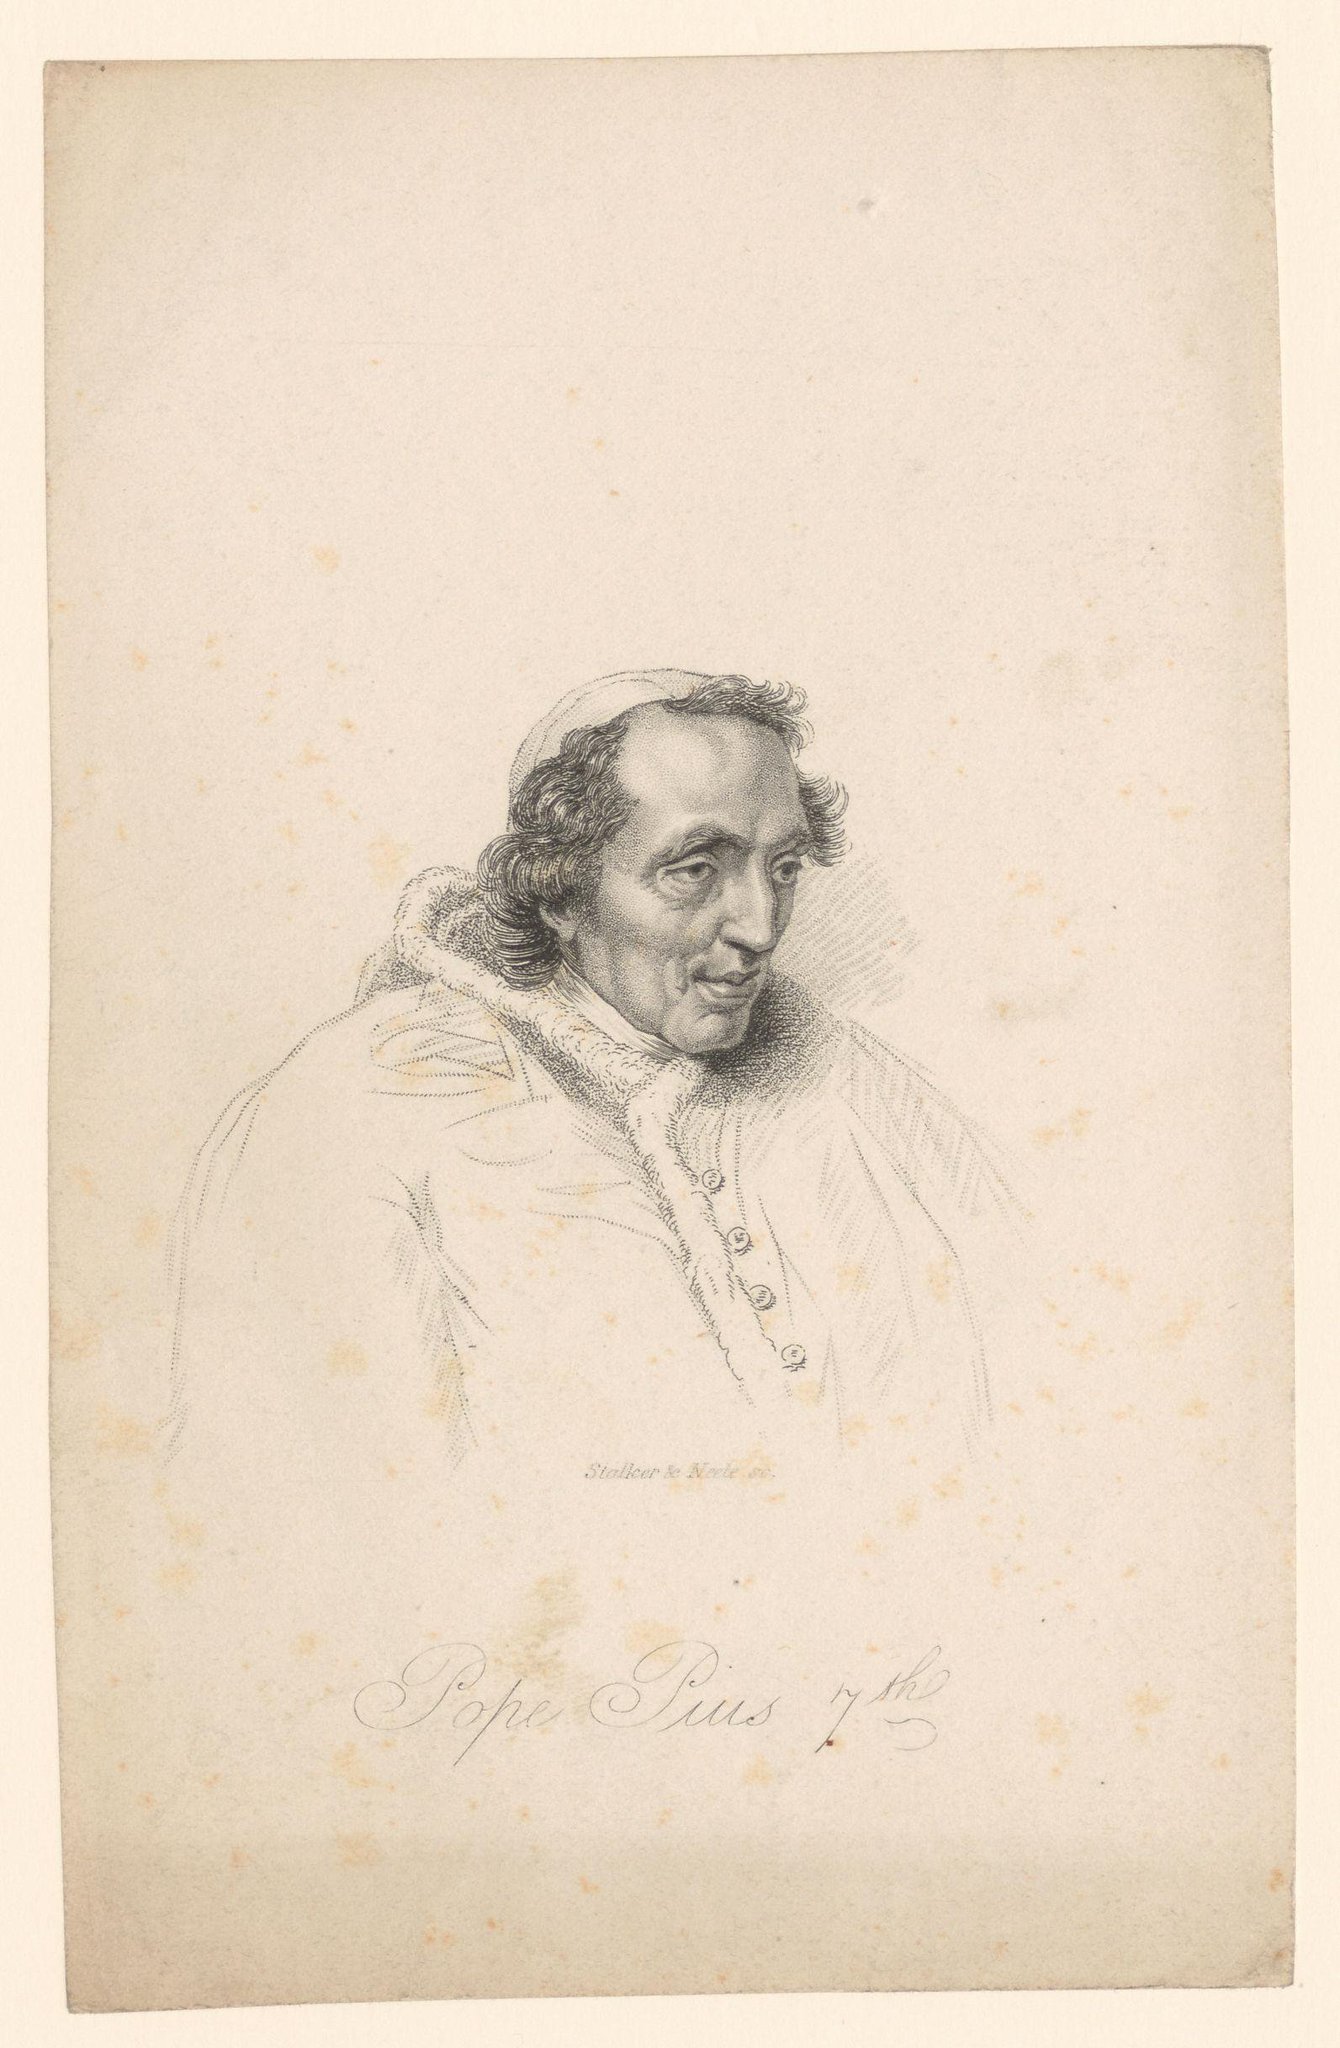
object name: print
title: Portret van Pius VII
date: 1820-1850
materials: paper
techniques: etching, roulette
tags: rome, clergyman, pius vii, historical persons, pope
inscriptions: collector's mark: Lugt 2228